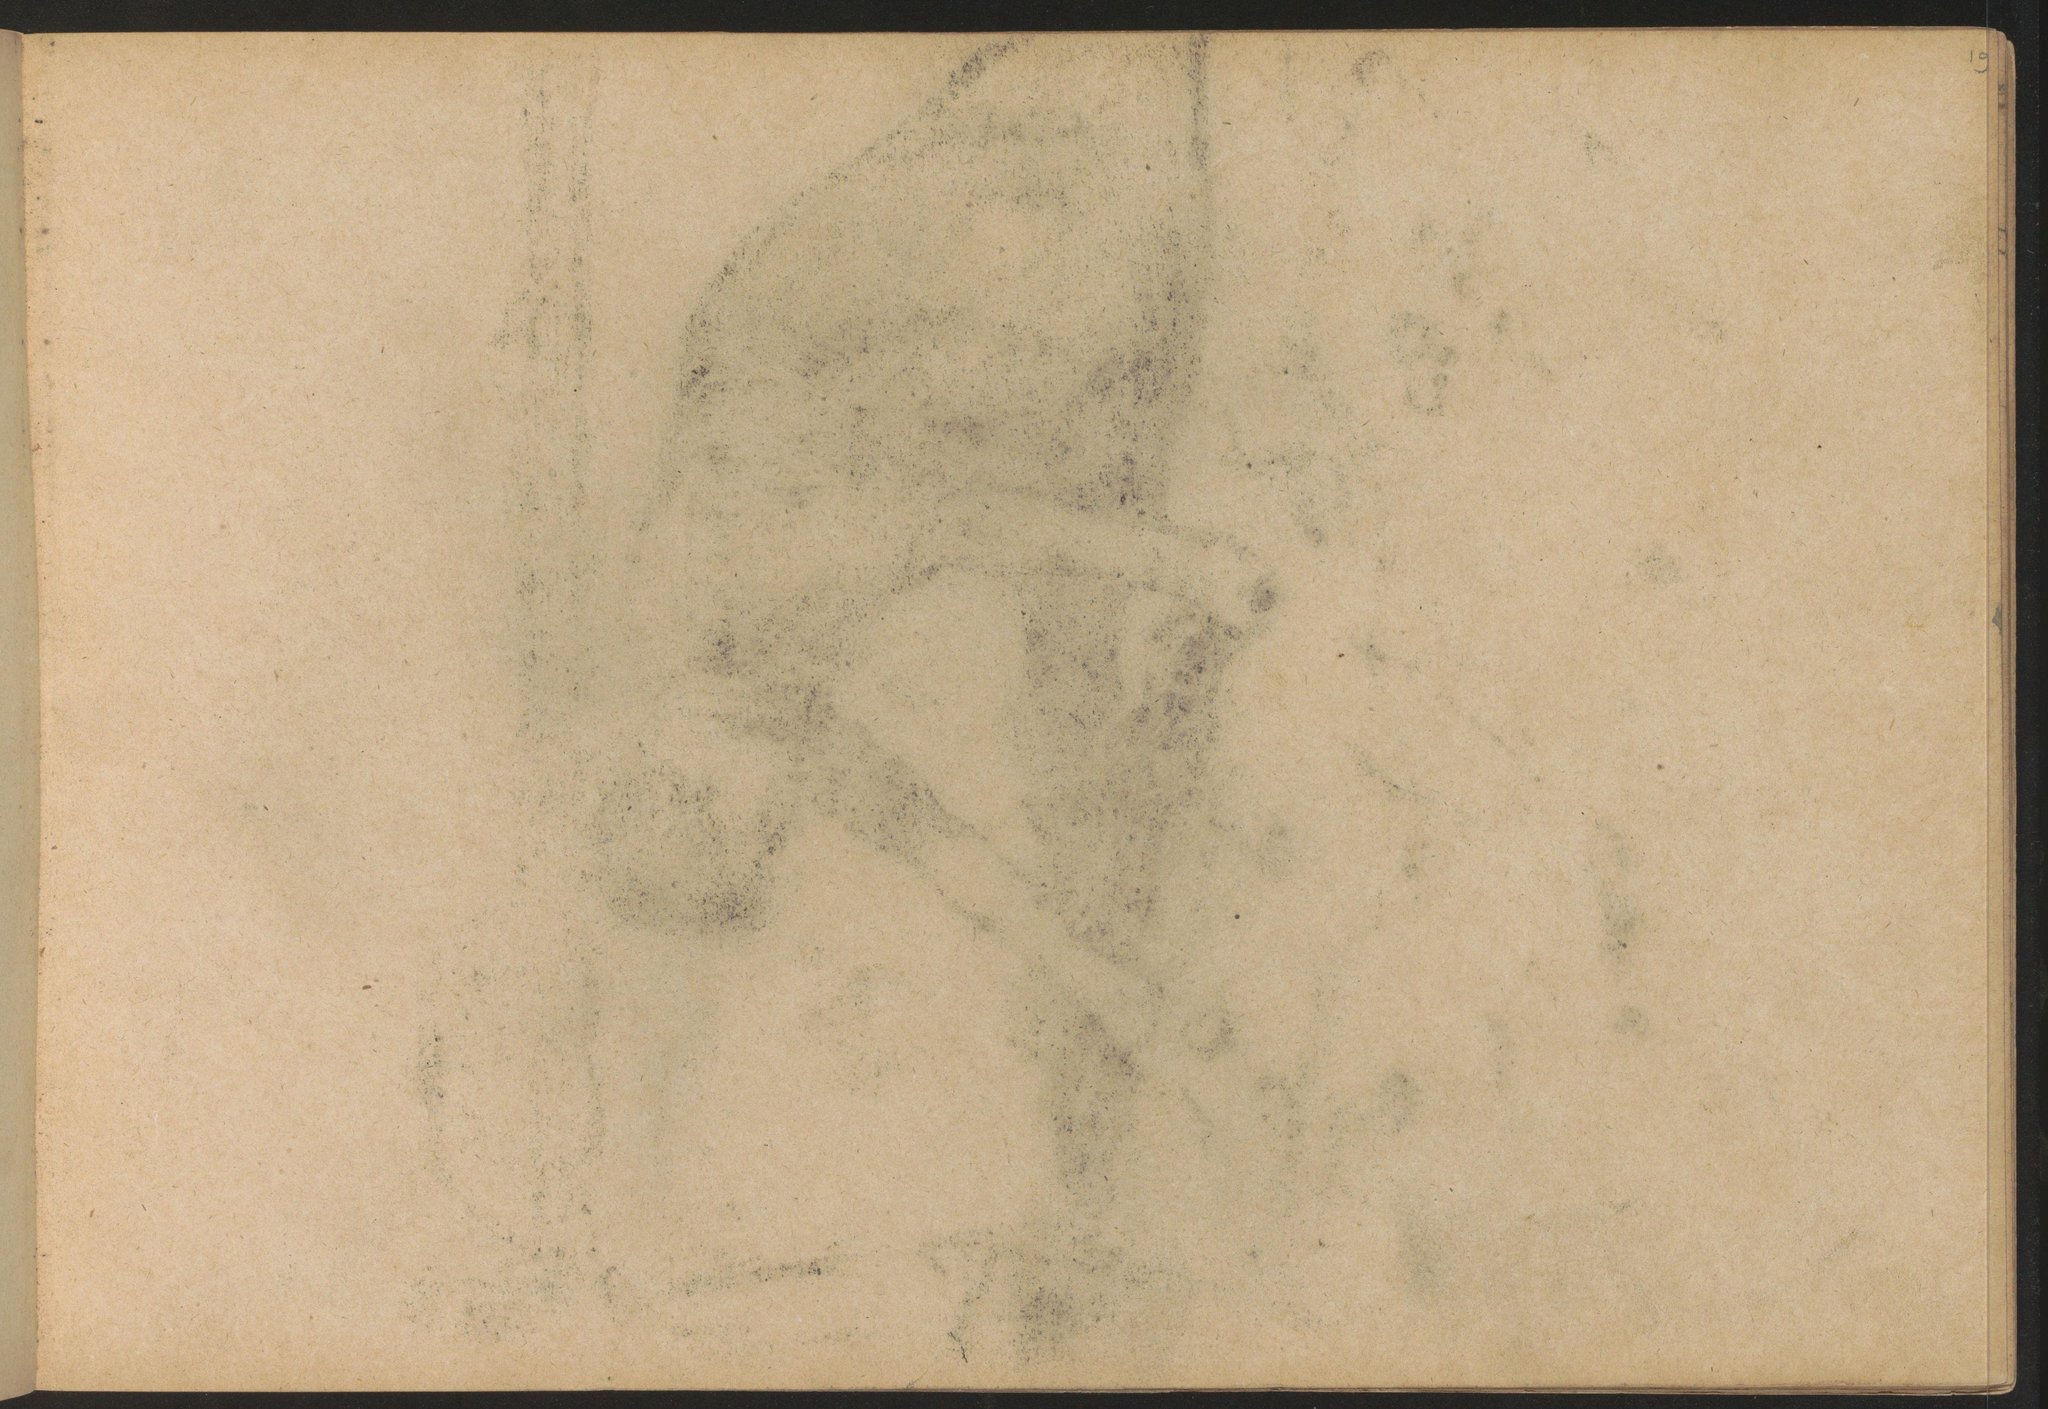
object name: sketchbook leaf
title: Abklatsch van de krijttekening op pagina 18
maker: willem witsen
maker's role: draughtsman, painter, print maker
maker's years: 1860-1923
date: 1882-1884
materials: paper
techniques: printmaking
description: Pagina 19 uit een schetsboek met 19 bladen.